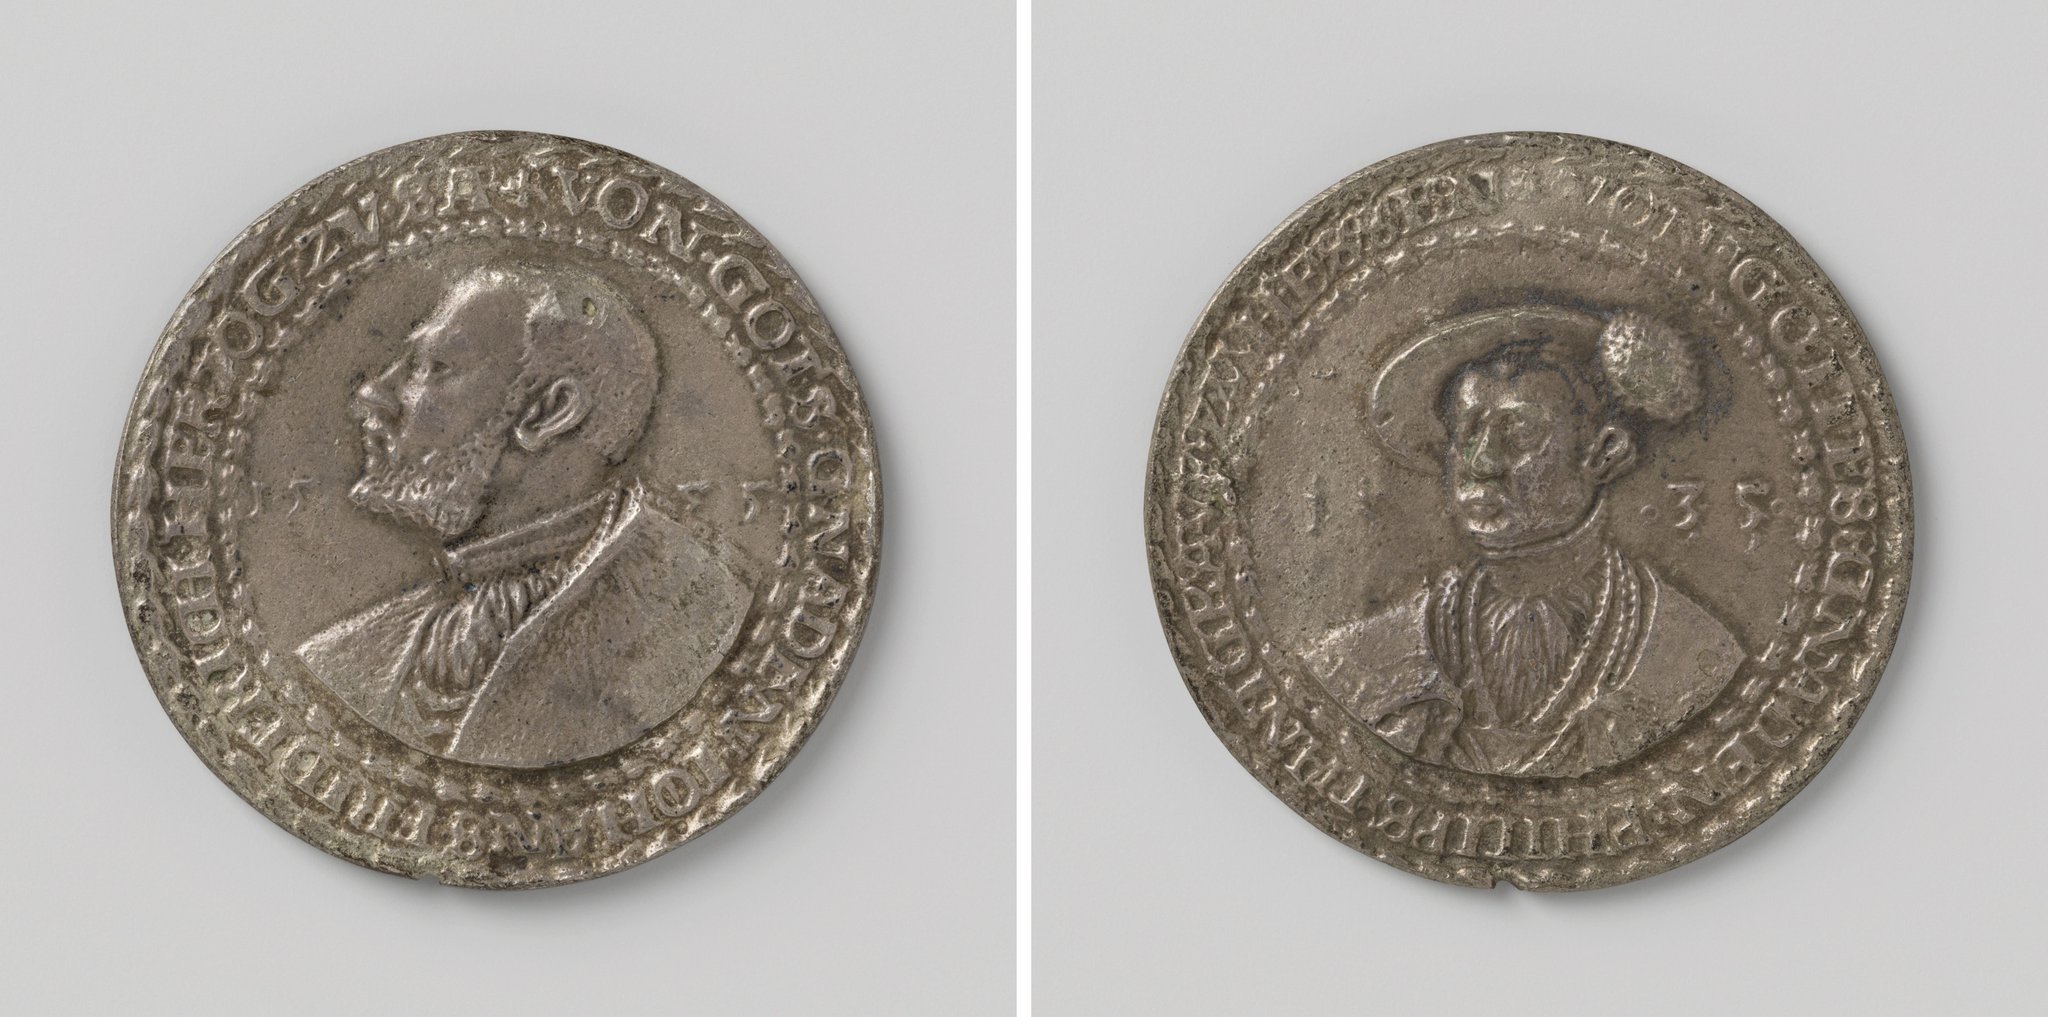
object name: history medal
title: Johan Frederik de Grootmoedige, keurvorst van Saksen en Filips de Grootmoedige, landgraaf van Hessen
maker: Anonymous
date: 1535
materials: silver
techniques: striking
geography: germany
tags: philip i (landgrave of hesse)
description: Zilveren penning. Voorzijde: borststuk man tussen jaartal, binnen omschrift. Keerzijde: borststuk man tussen jaartal, binnen omschrift